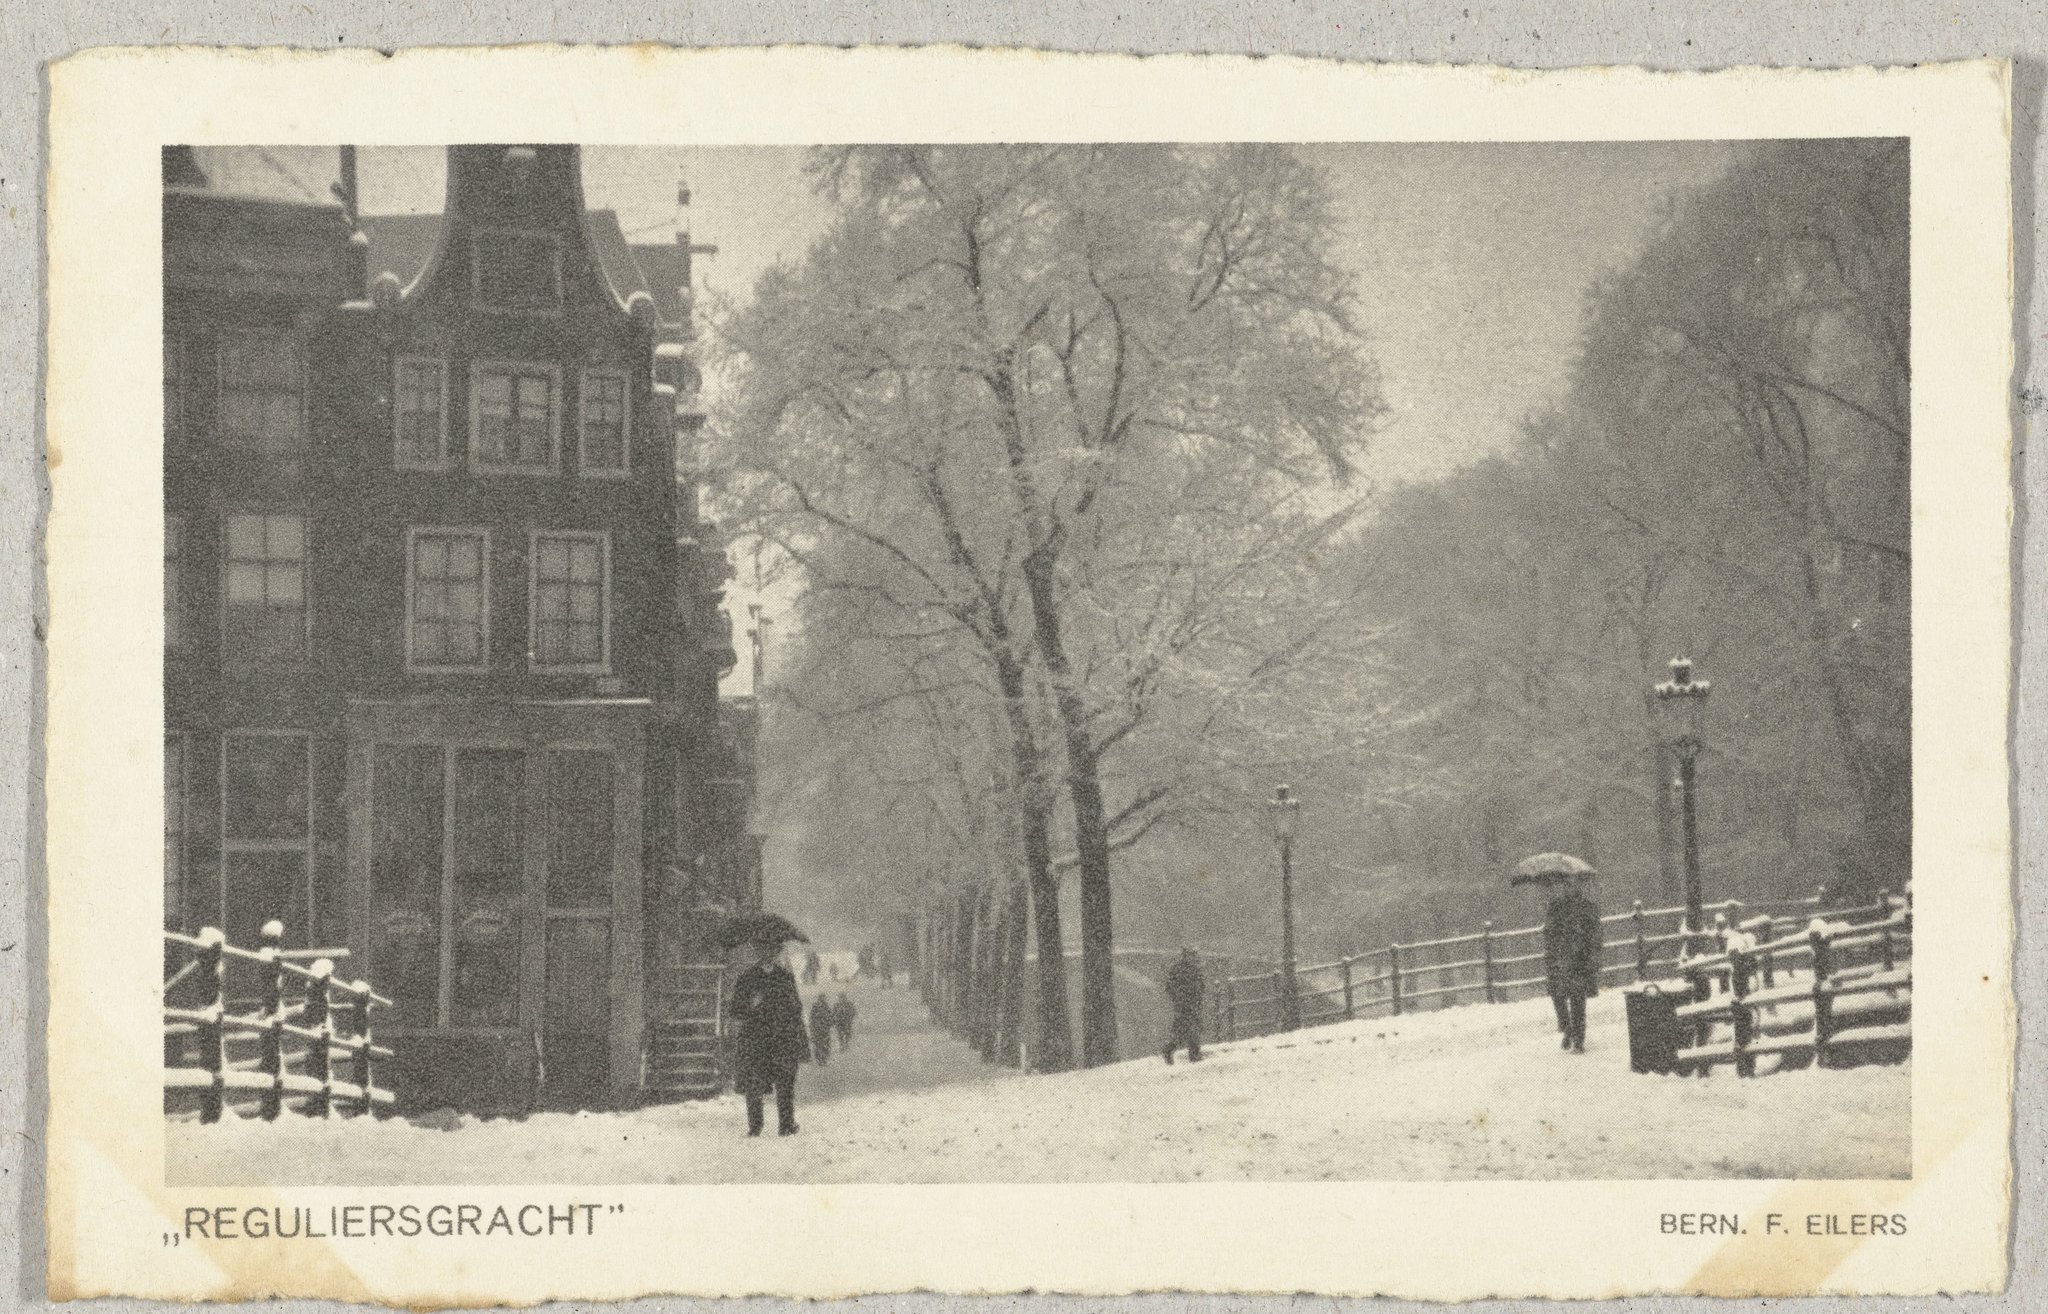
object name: ansichtkaart, prentbriefkaart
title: Amsterdam Reguliersgracht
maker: bernard eilers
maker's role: fotograaf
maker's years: 1878-1951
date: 1913-1940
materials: paper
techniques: rotogravure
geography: amsterdam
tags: bridge in city across river, canal, etc. (+ city(-scape) with figures, staffage), snow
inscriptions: inscription: ‘AMSTERDAM - REGULIERSGRACHT. / NAAM / ADRES / W. & S. H. / 24-6633’, inscription: ‘"REGULIERSGRACHT" BERN. F. EILERS’